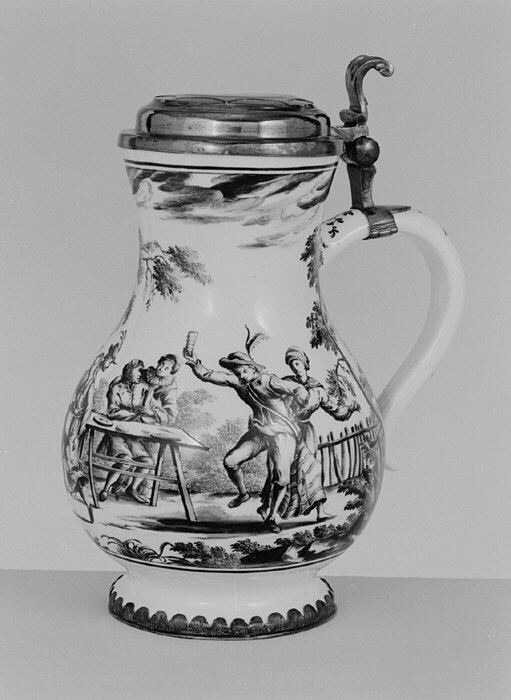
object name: tankard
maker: vienna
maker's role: manufactory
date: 1740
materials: hard paste porcelain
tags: men,women